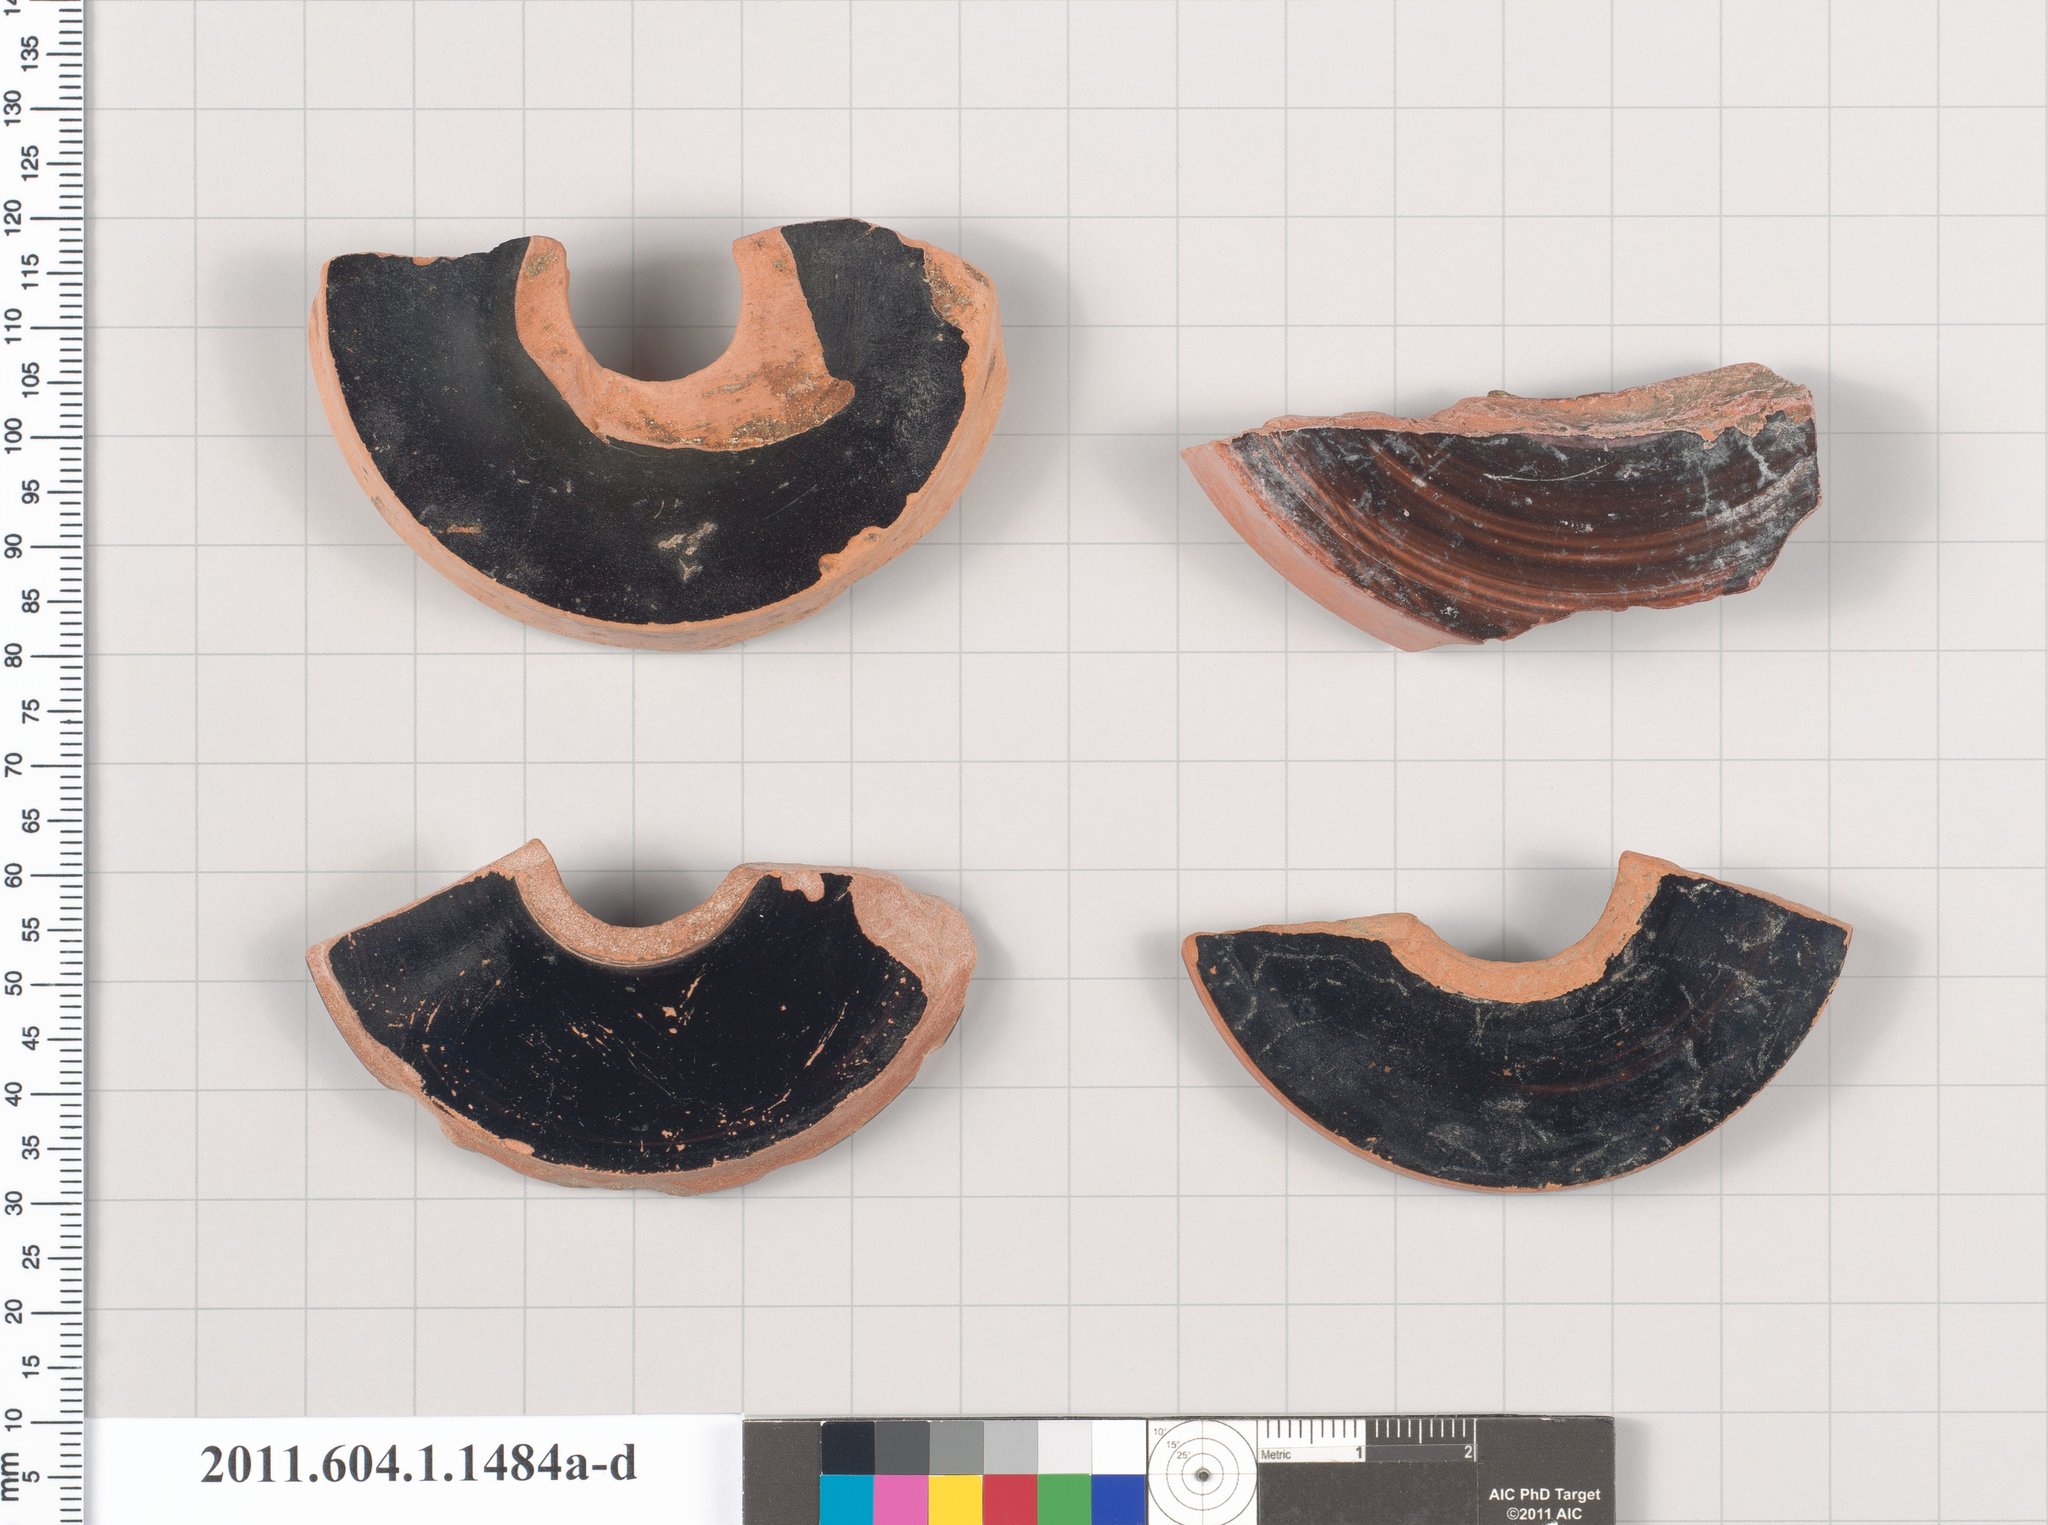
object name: kylix fragment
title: Terracotta fragments of kylikes (drinking cups)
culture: greek, attic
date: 500-401 BCE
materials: terracotta